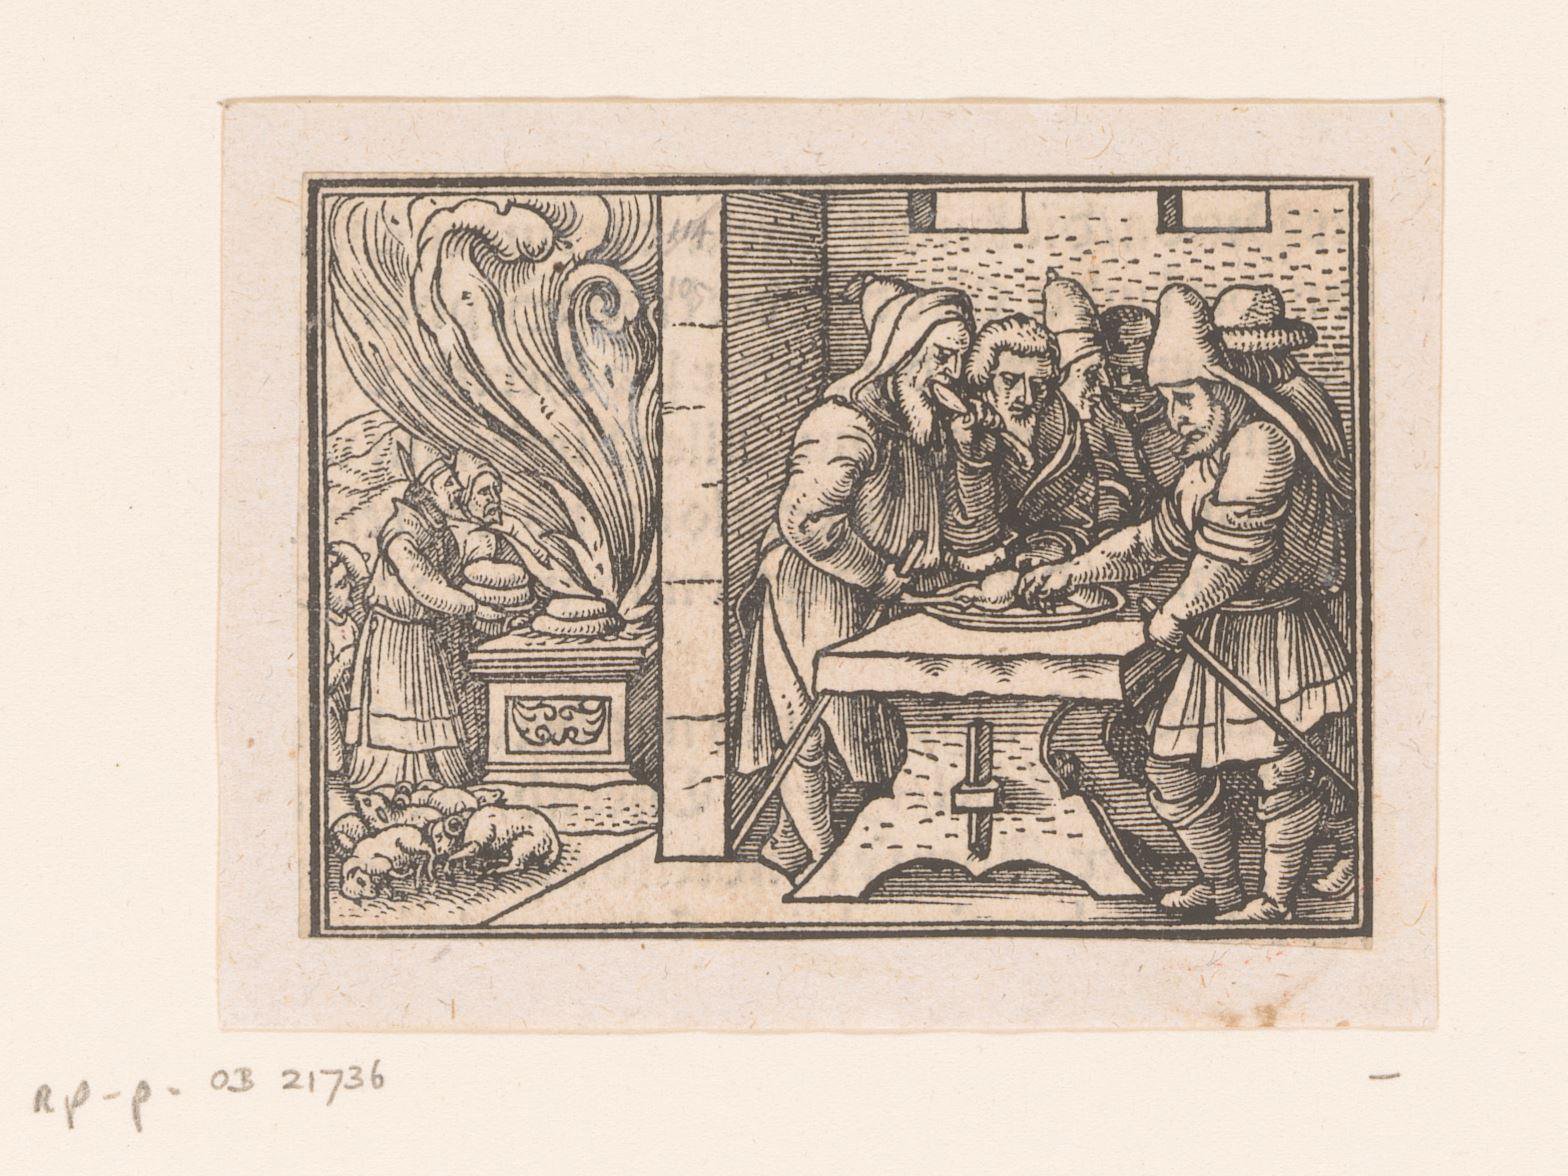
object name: print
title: Josia viert Pesach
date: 1522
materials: paper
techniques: woodcut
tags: the animals are killed and roasted over fire; other offerings are boiled in pots and cauldrons ~ josiah celebrating the passover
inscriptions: collector's mark: Lugt 240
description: Mogelijk een kopie van een prent van Hans Holbein de jongere. Niet uit de Icones historiarum Veteris Testamenti van 1538. Deze kopie mogelijk uit: Biblia sacra iuxta vulgatam. Parijs: Jean Benoît, 1552. Ook aanwezig in de Herzog August Bibliothek: http://diglib.hab.de?grafik=graph-res-d-326-1.